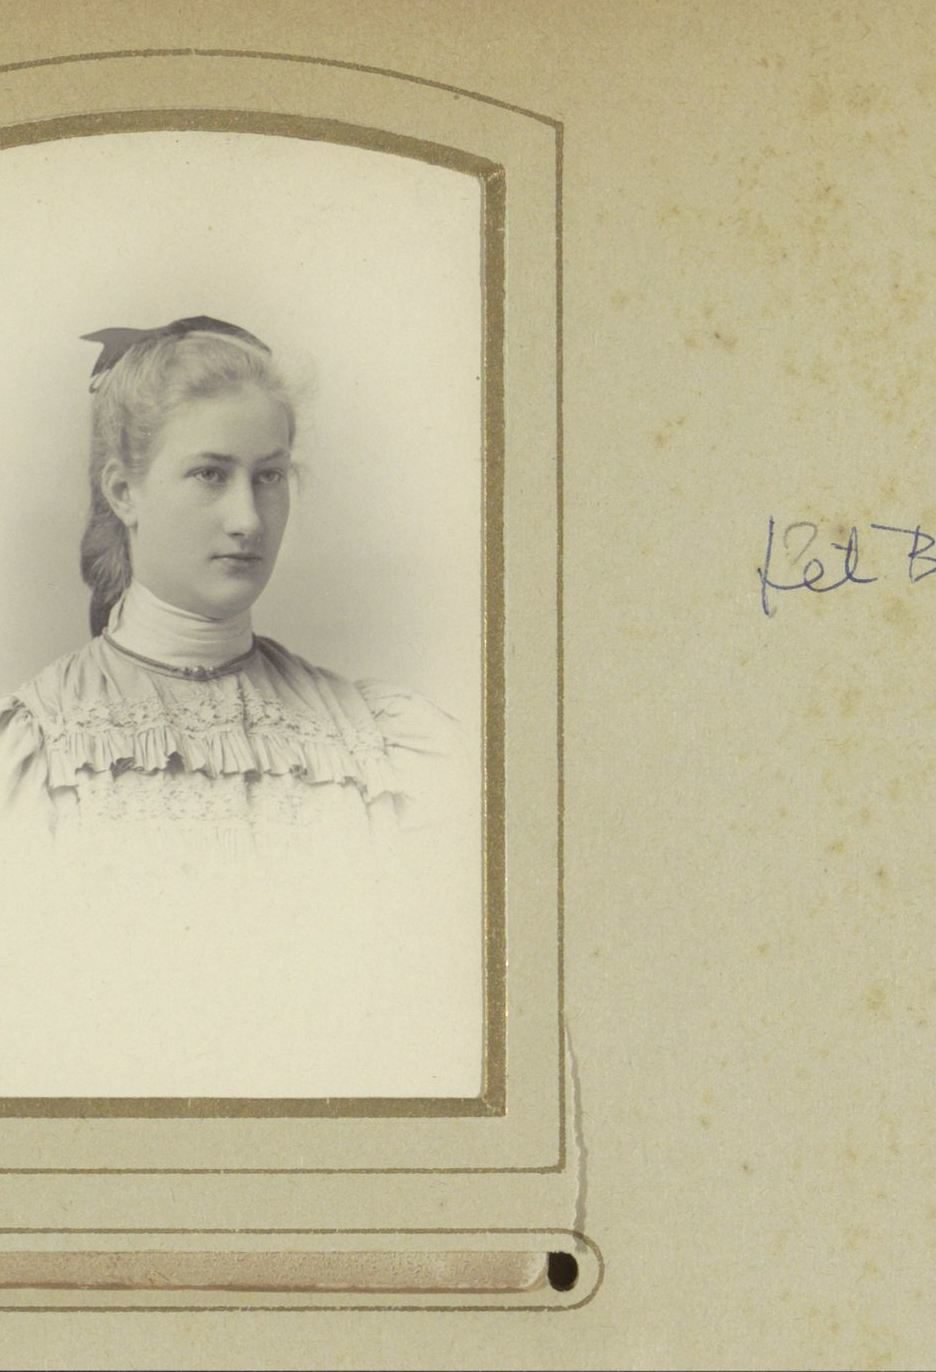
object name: photograph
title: Portret van Jet Boelen als jong meisje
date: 1890-1910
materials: cardboard, paper, photographic support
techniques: matte daylight collodion silver print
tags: adolescent, young woman, maiden, historical persons - bb - woman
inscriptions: address: ‘Amsterdam Heerengracht 150 / Batavia’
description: Onderdeel van Fotoalbum van de familie Boelen.